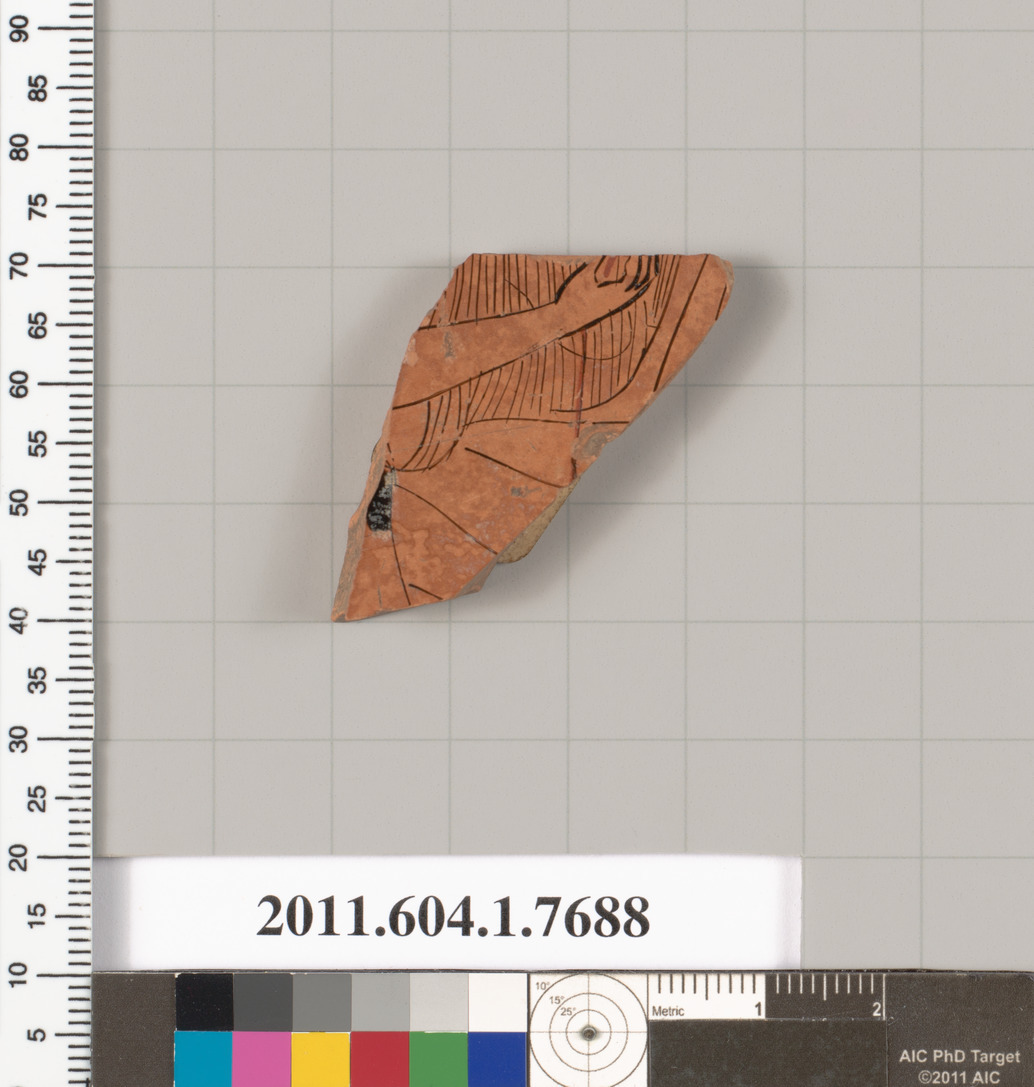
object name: kylix fragment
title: Terracotta fragment of a kylix (drinking cup)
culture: greek, attic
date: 470-460 BCE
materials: terracotta